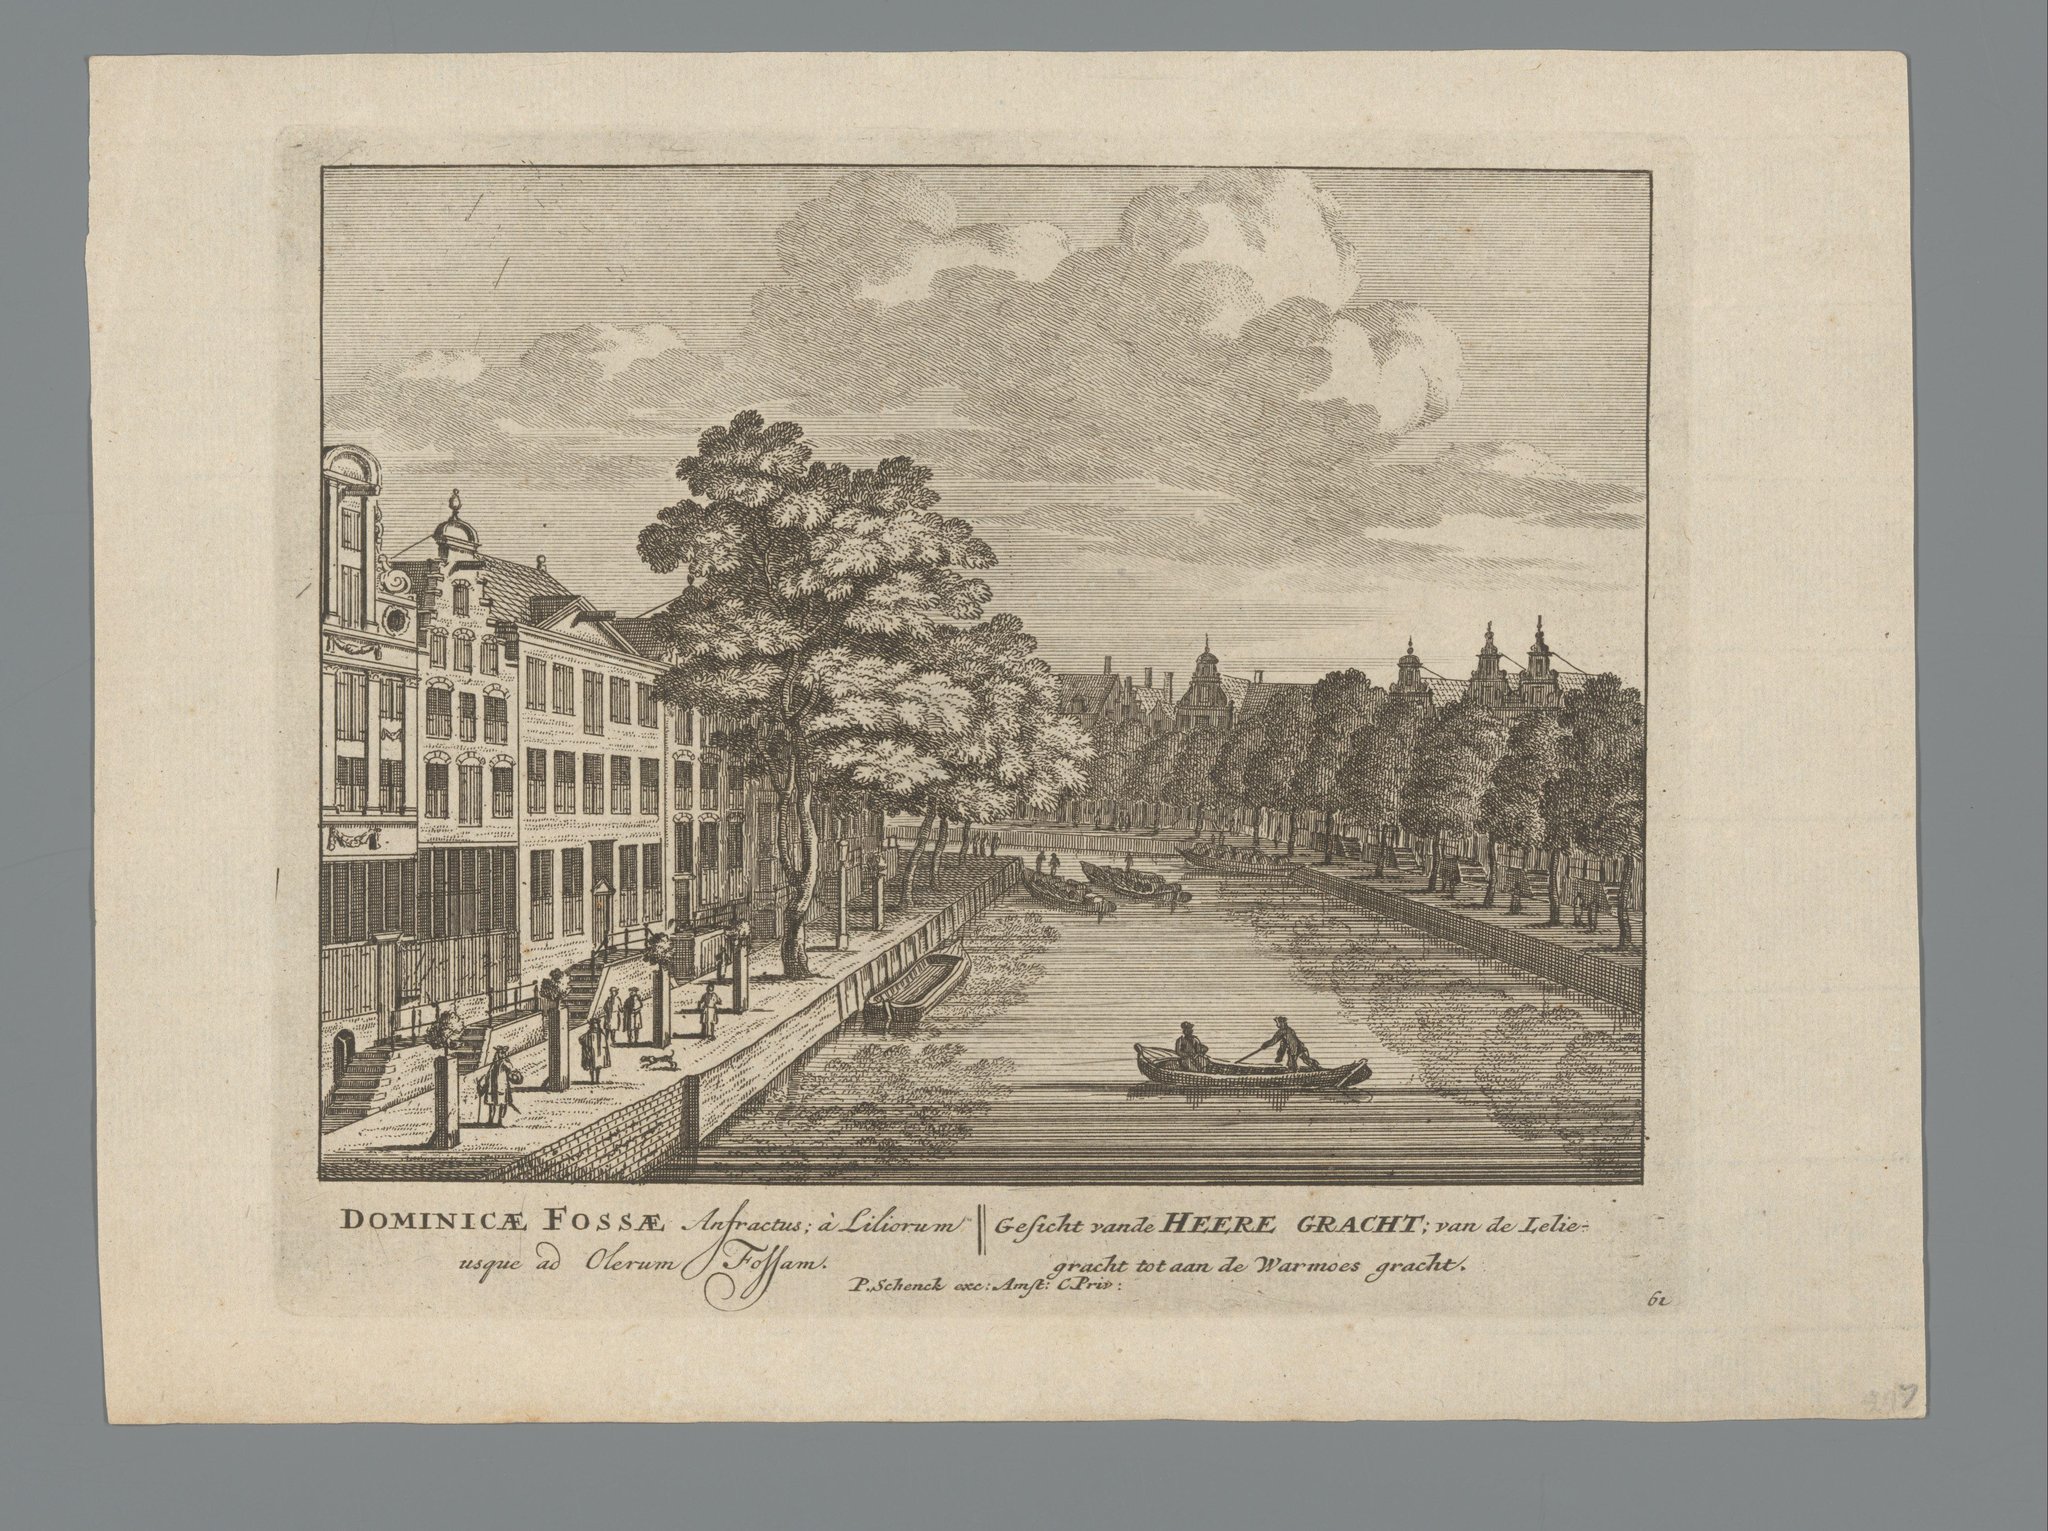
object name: print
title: 100 Afbeeldinge der voornaamste gebouwen van Amsterdam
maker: Anonymous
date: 1710-1711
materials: paper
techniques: etching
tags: canals, waters (in city)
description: Prent verschenen in: 100 Afbeeldinge der voornaamste gebouwen van Amsterdam. Amsterdam: Pieter Schenk (I), [1710-1711]. En in: 100 Afbeeldinge der voornaamste gebouwen van Amsterdam. Amsterdam: Barent Greve, [1757-1766].* *In de tweede uitgave, uitgegeven door Barent Greve, is alleen de titelprent aangepast. De overige prenten zijn onveranderd gebleven.